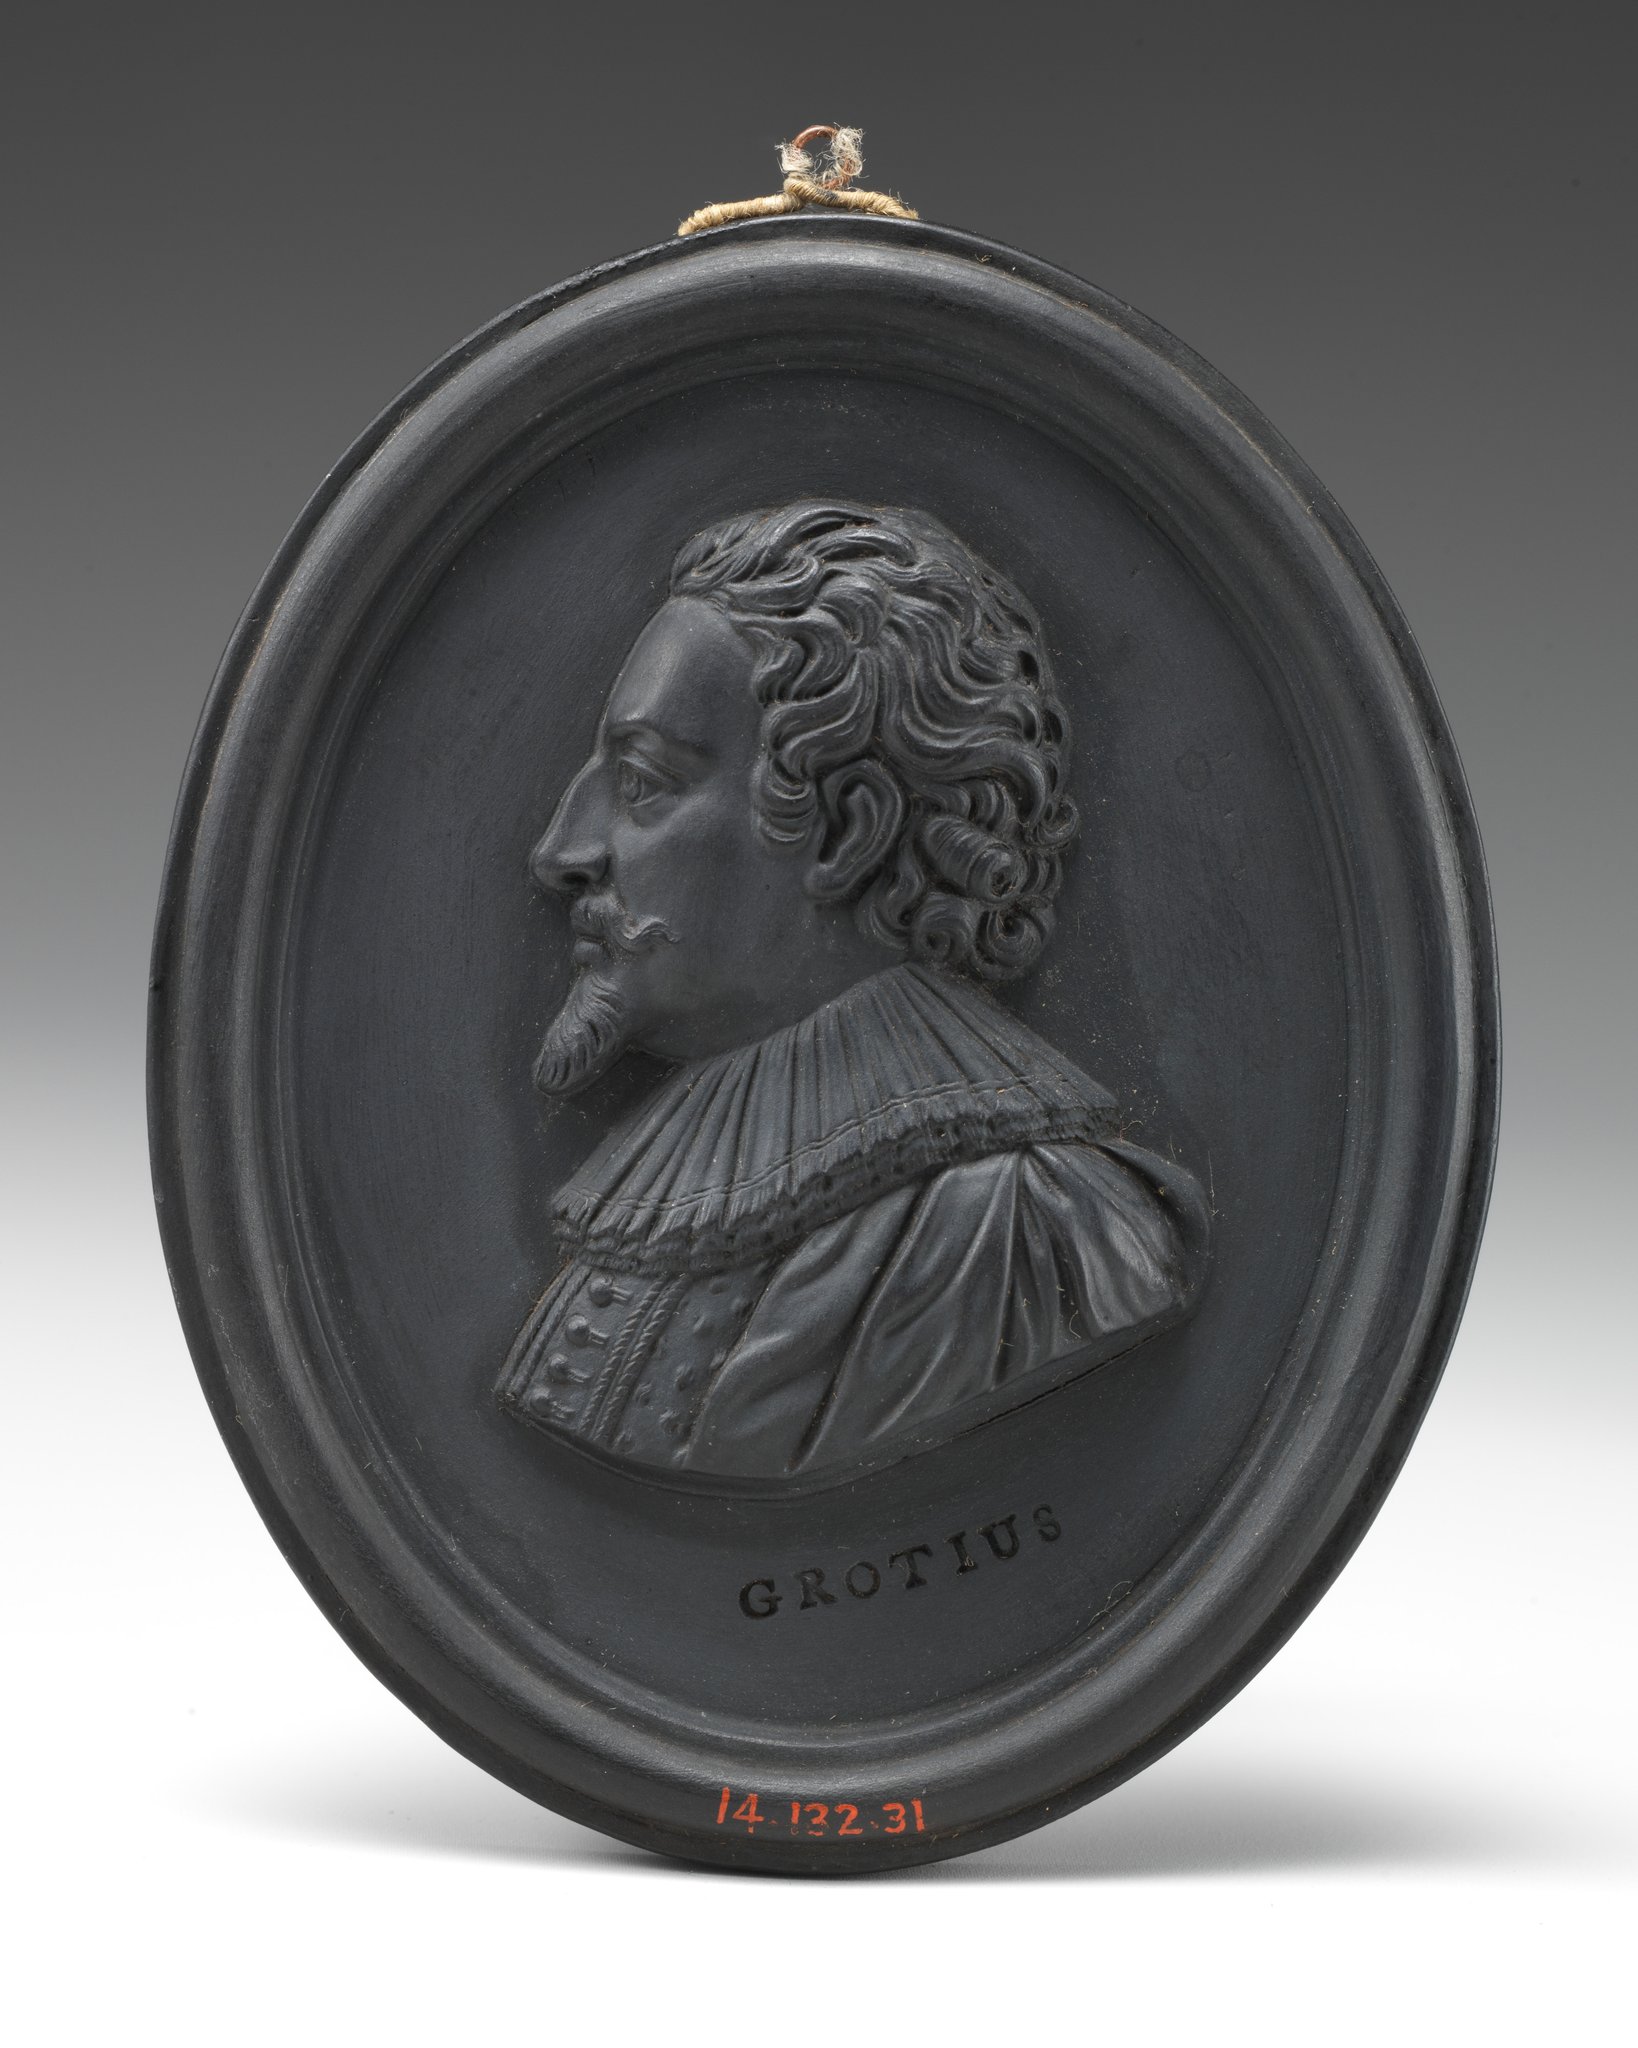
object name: medallion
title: Hugo Grotius (1583–1645)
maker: wedgwood and bentley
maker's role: maker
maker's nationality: british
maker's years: 1769-1780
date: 1701-1800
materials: stone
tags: men,profiles